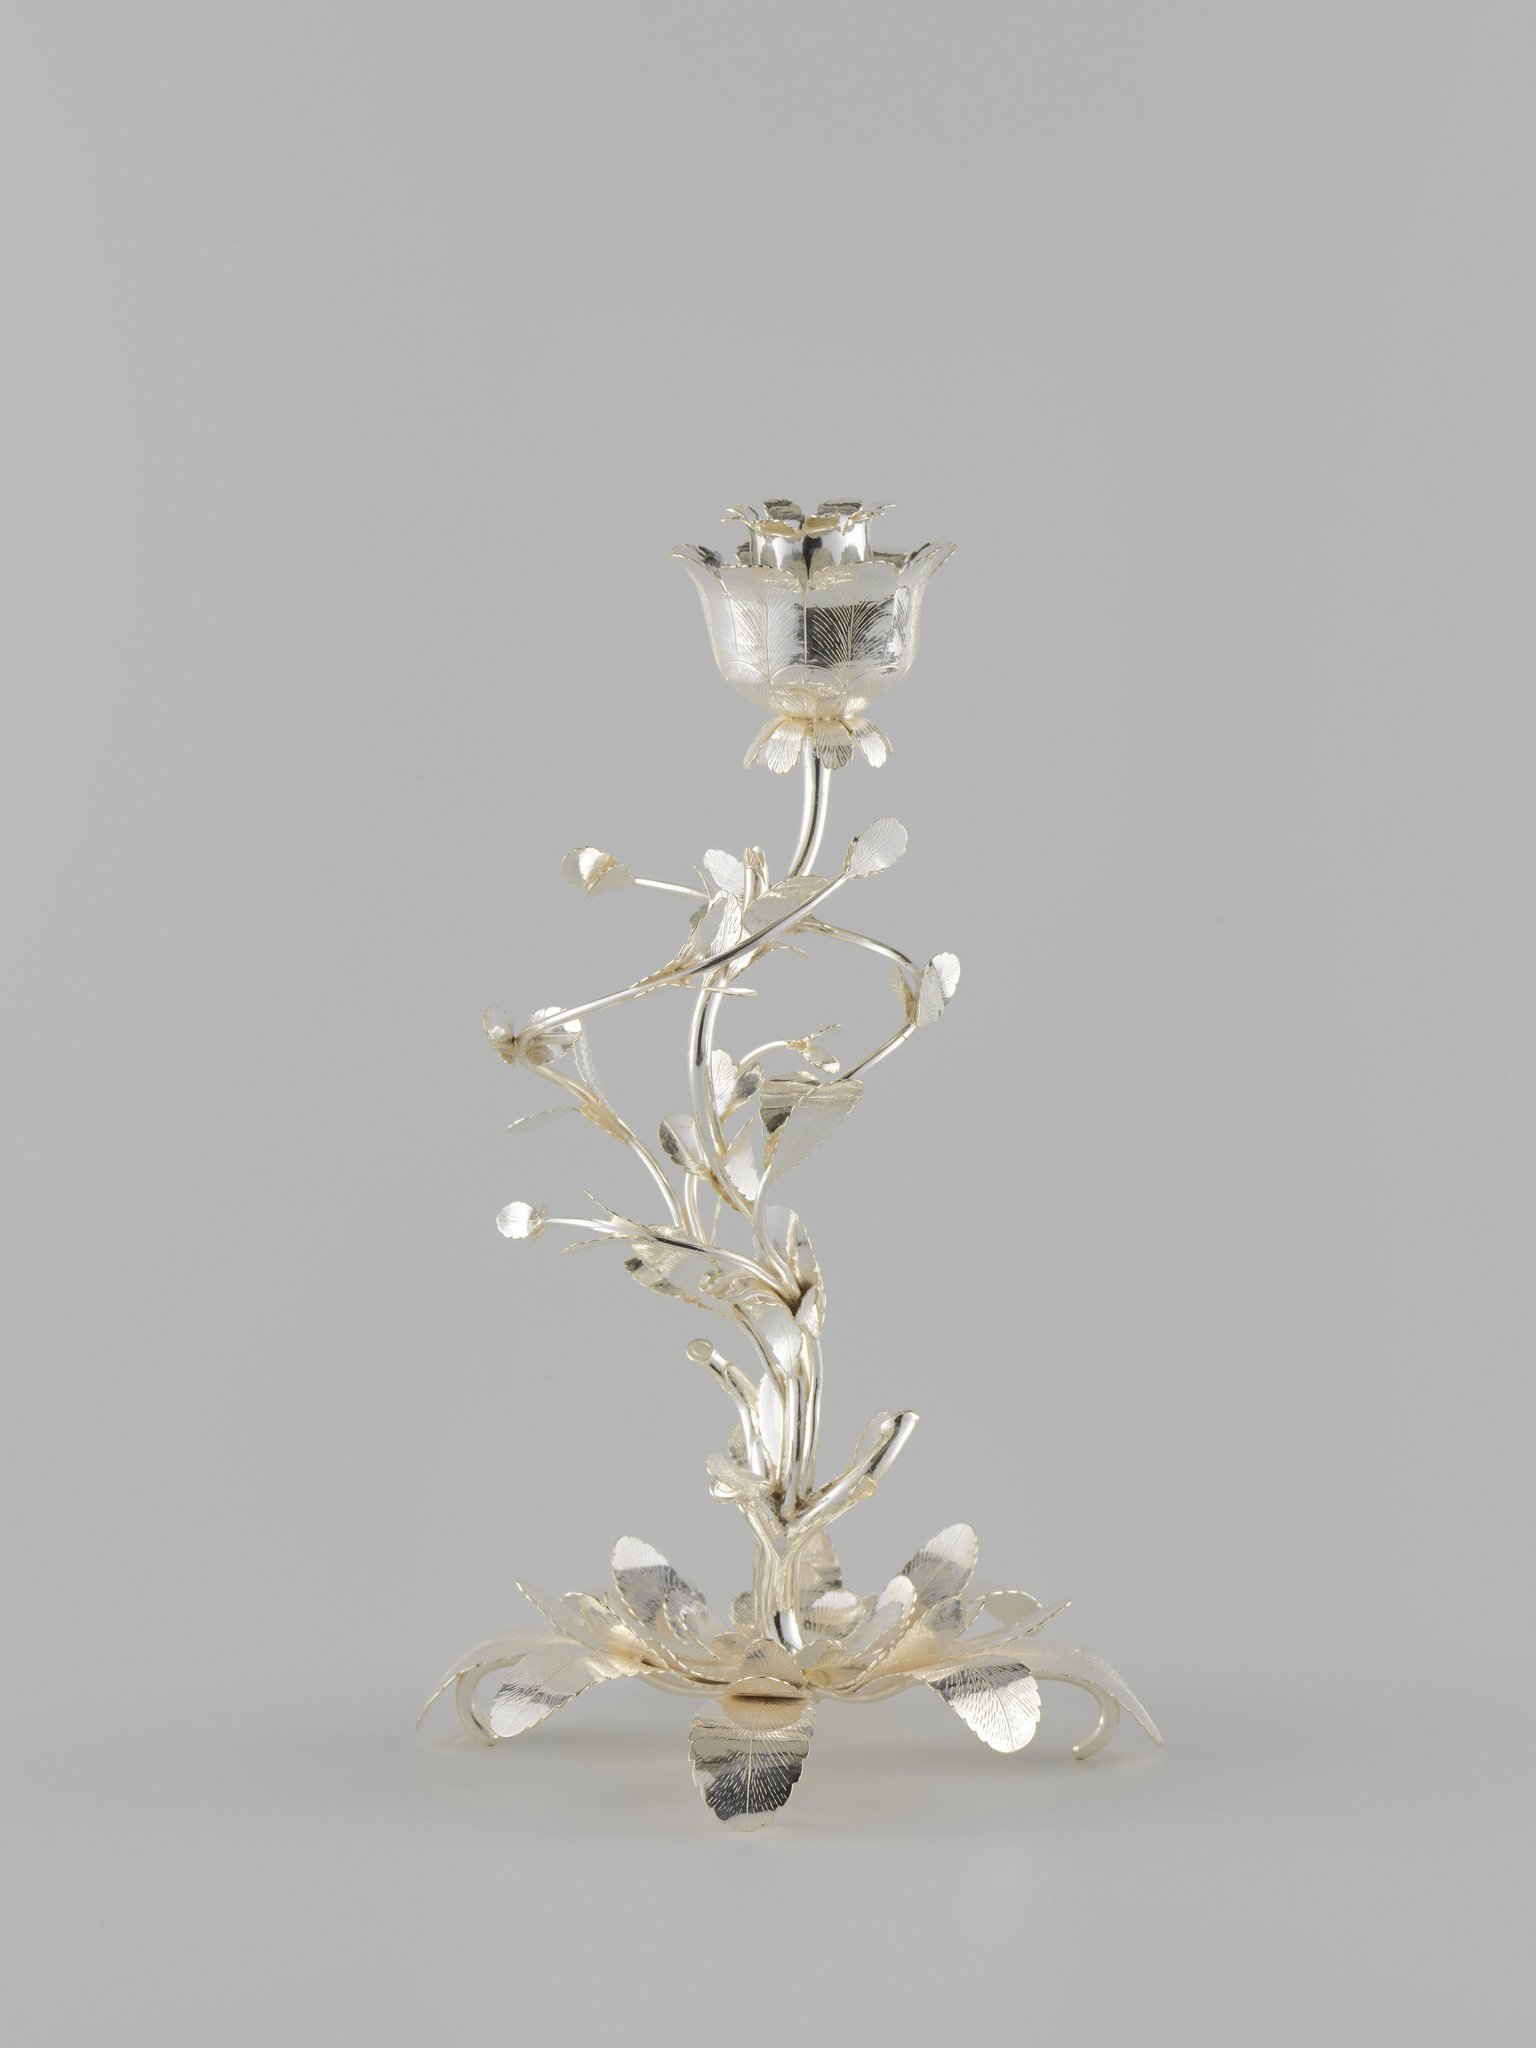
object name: candlestick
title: Kandelaar van zilver met stam in de vorm van een gekronkelde boomstam met drie slingerende takken met ovale bladeren en kaarsenhouder in bloemkroon.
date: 1784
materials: silver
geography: dordrecht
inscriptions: mark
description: Kandelaar van zilver. Uit een bladrozet rijst een kronkelende boomstam, die zich verdeelt in drie slingerende takken met ovale bladeren. De kaarsenhouder is gevat in een bloemkroon.